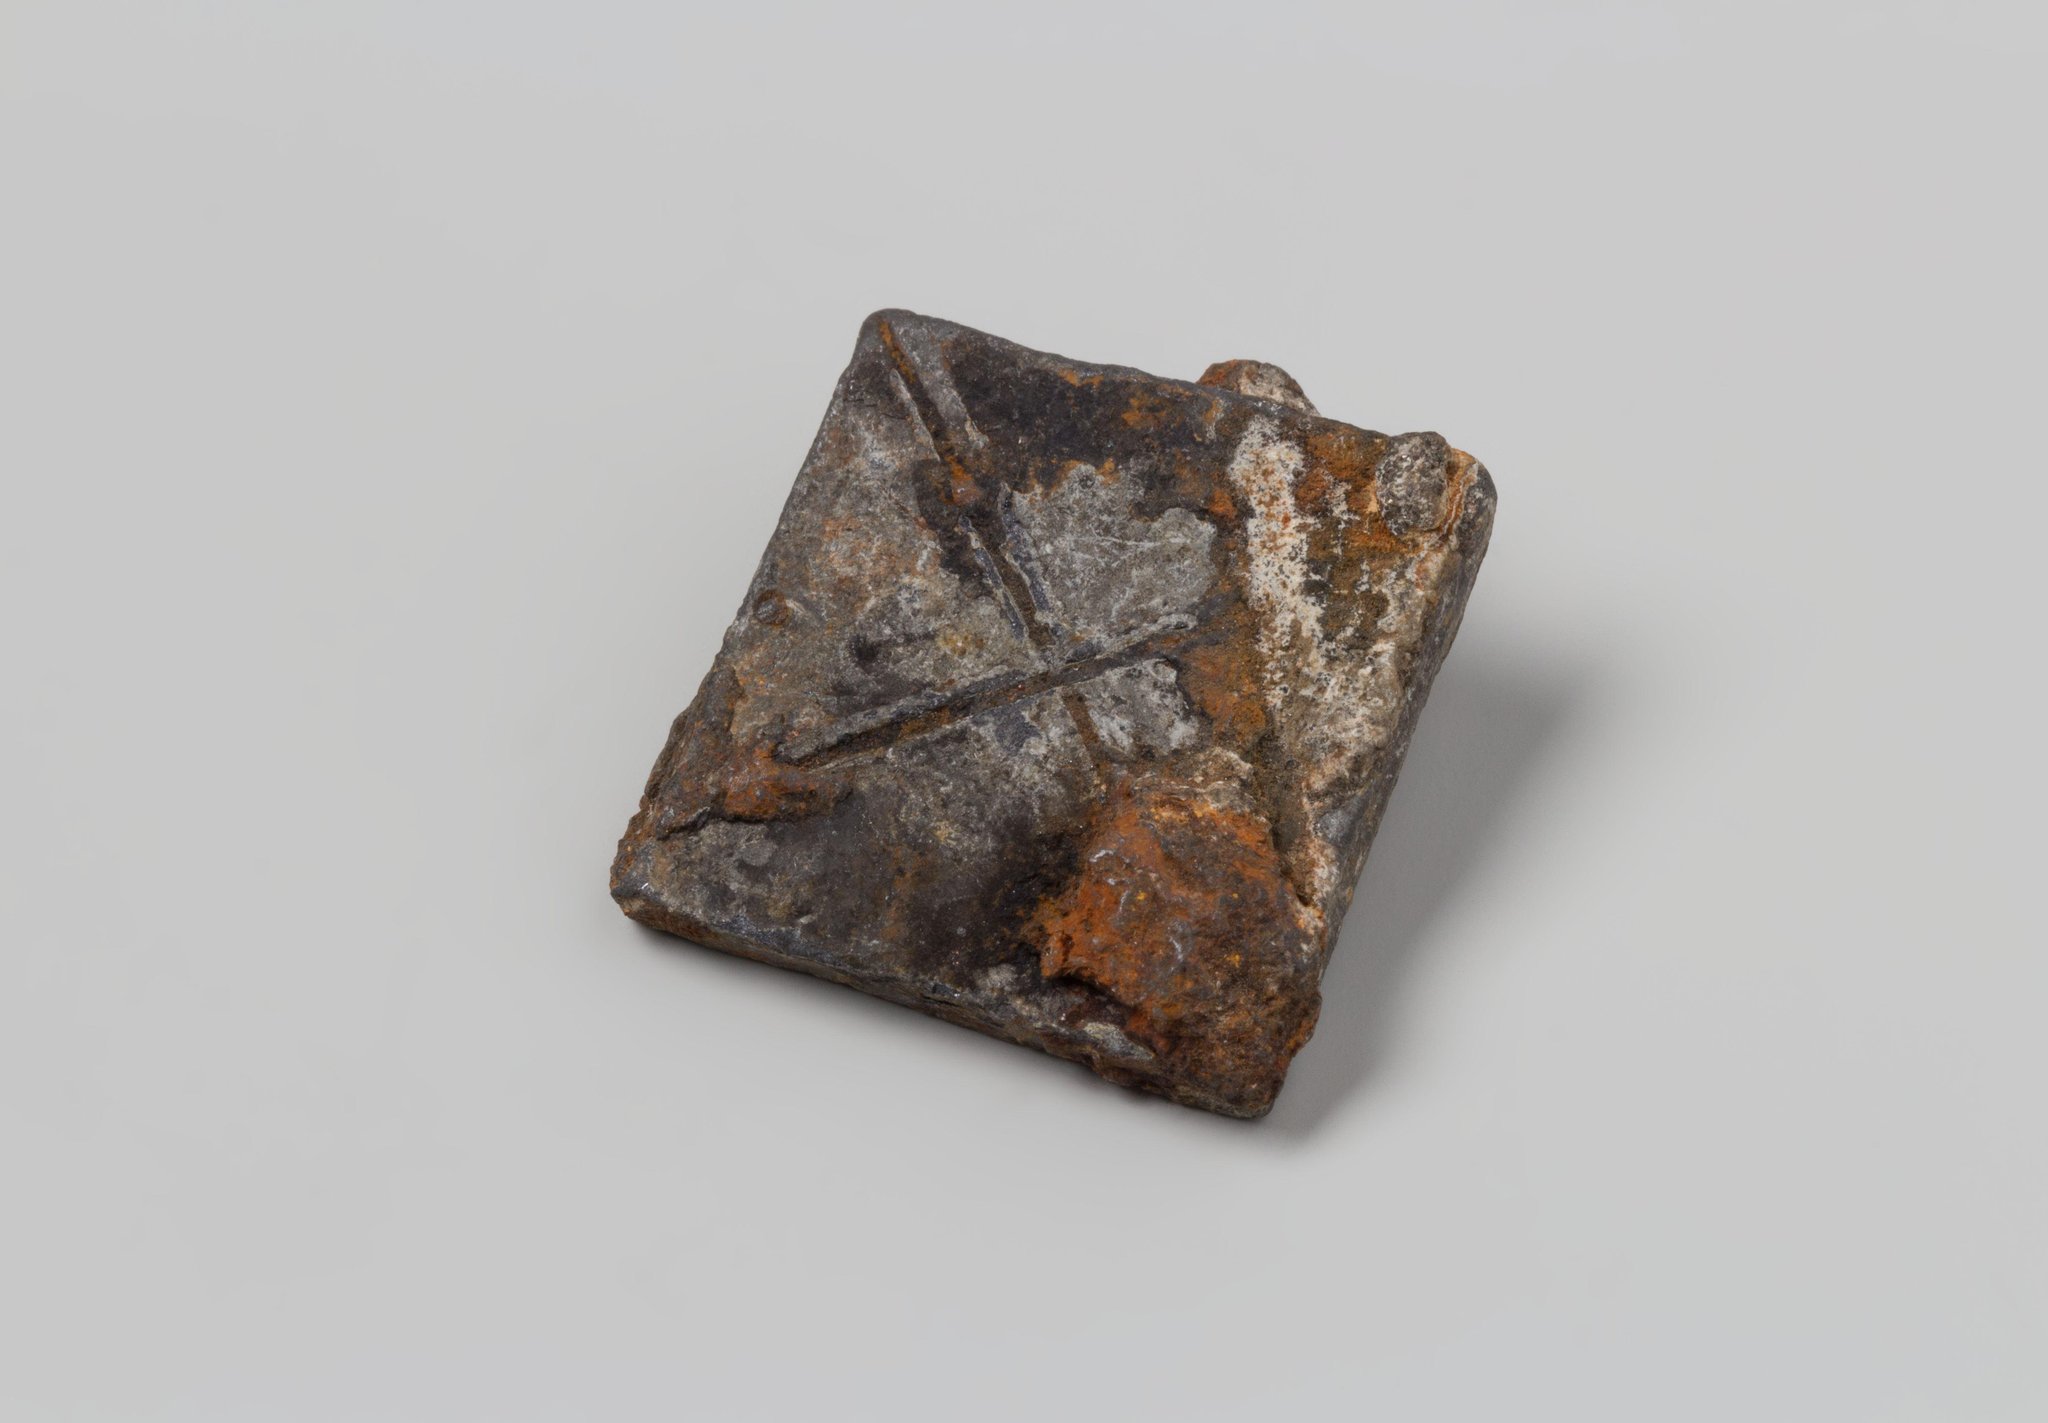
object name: gaming counter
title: Speelpenning uit het wrak van de Oost-Indiëvaarder Hollandia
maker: Anonymous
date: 1700-1743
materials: lead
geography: netherlands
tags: verenigde oostindische compagnie, hollandia (schip), annet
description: Rectangular, square, flat, engraved diagonal cross on one side, game token.